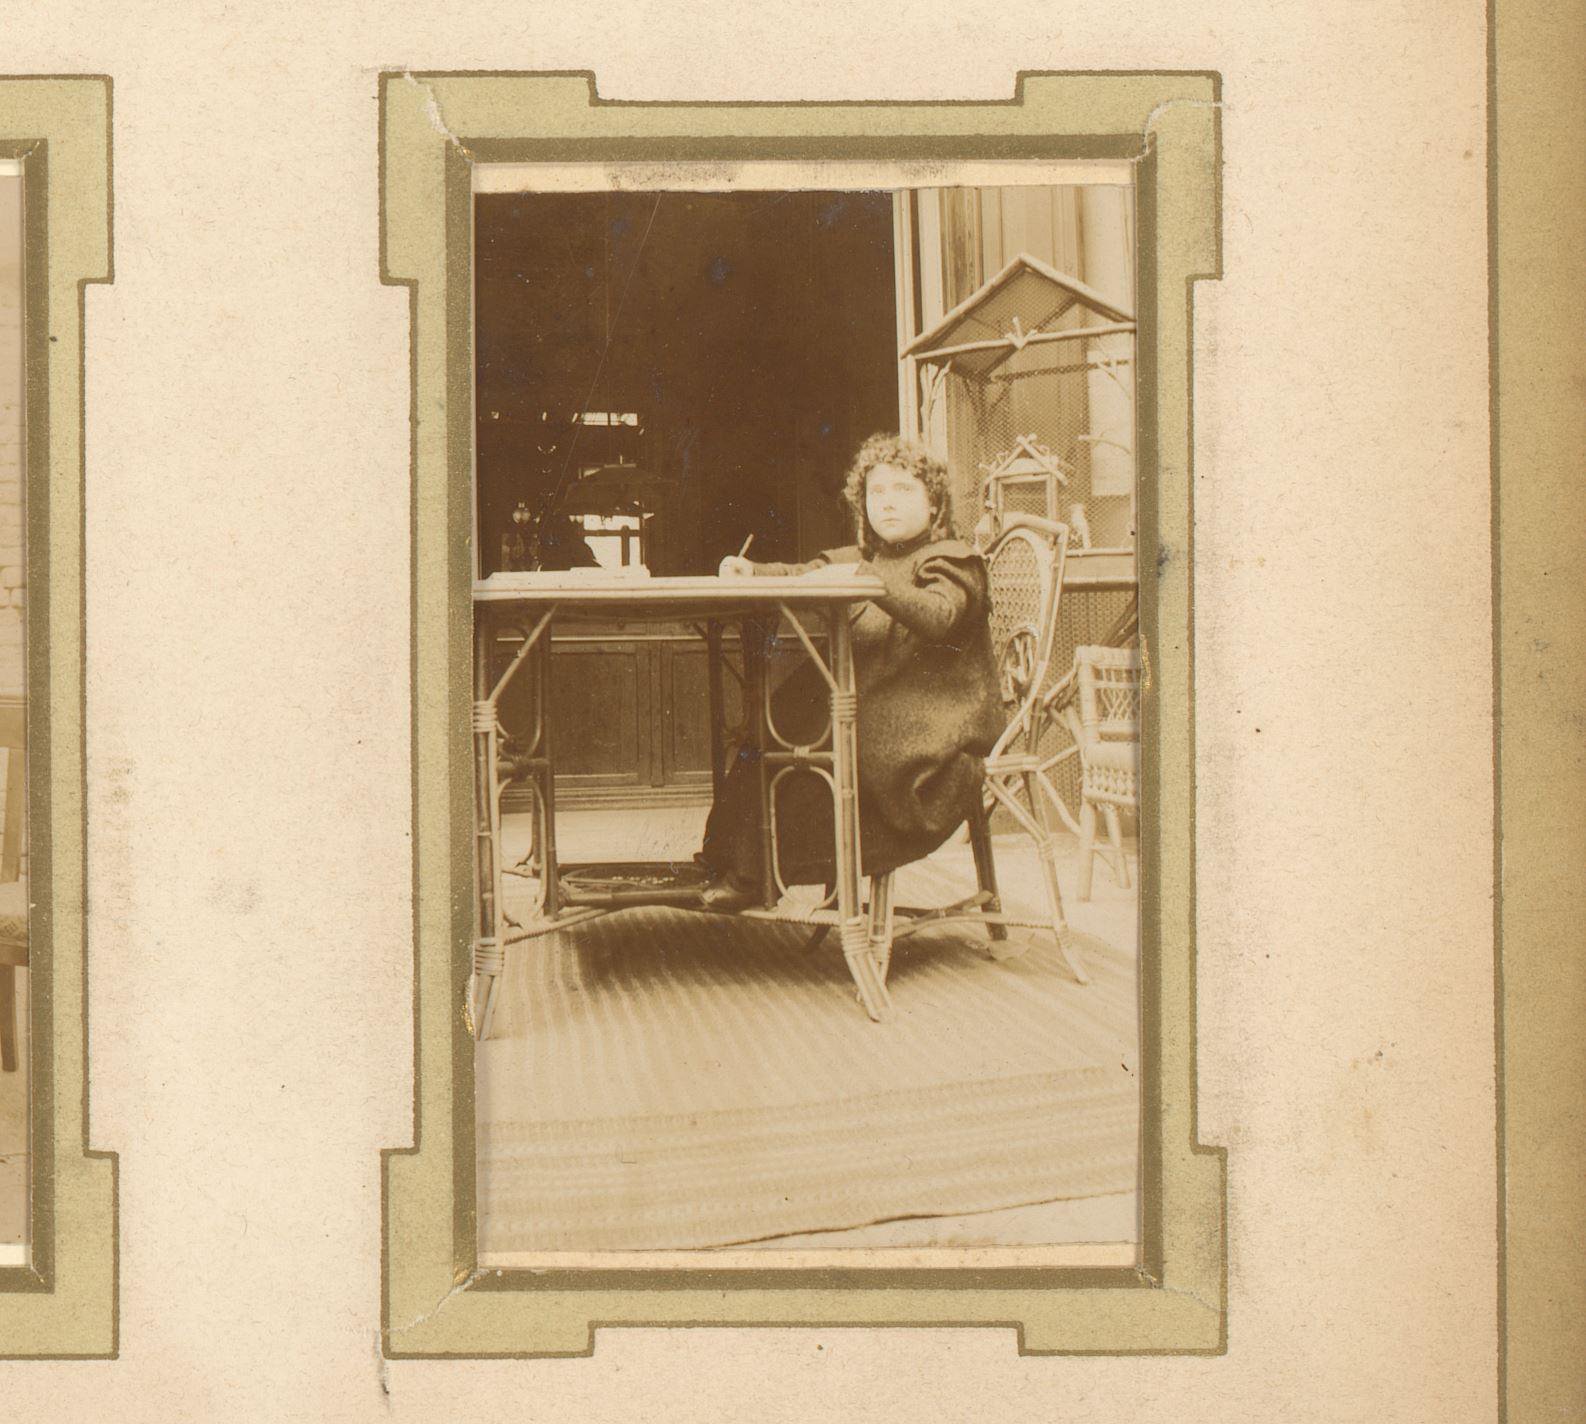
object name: carte de visite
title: Portret van een zittend meisje aan tafel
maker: Anonymous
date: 1860-1900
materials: cardboard, photographic support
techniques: albumen print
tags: girl (child between toddler and youth)